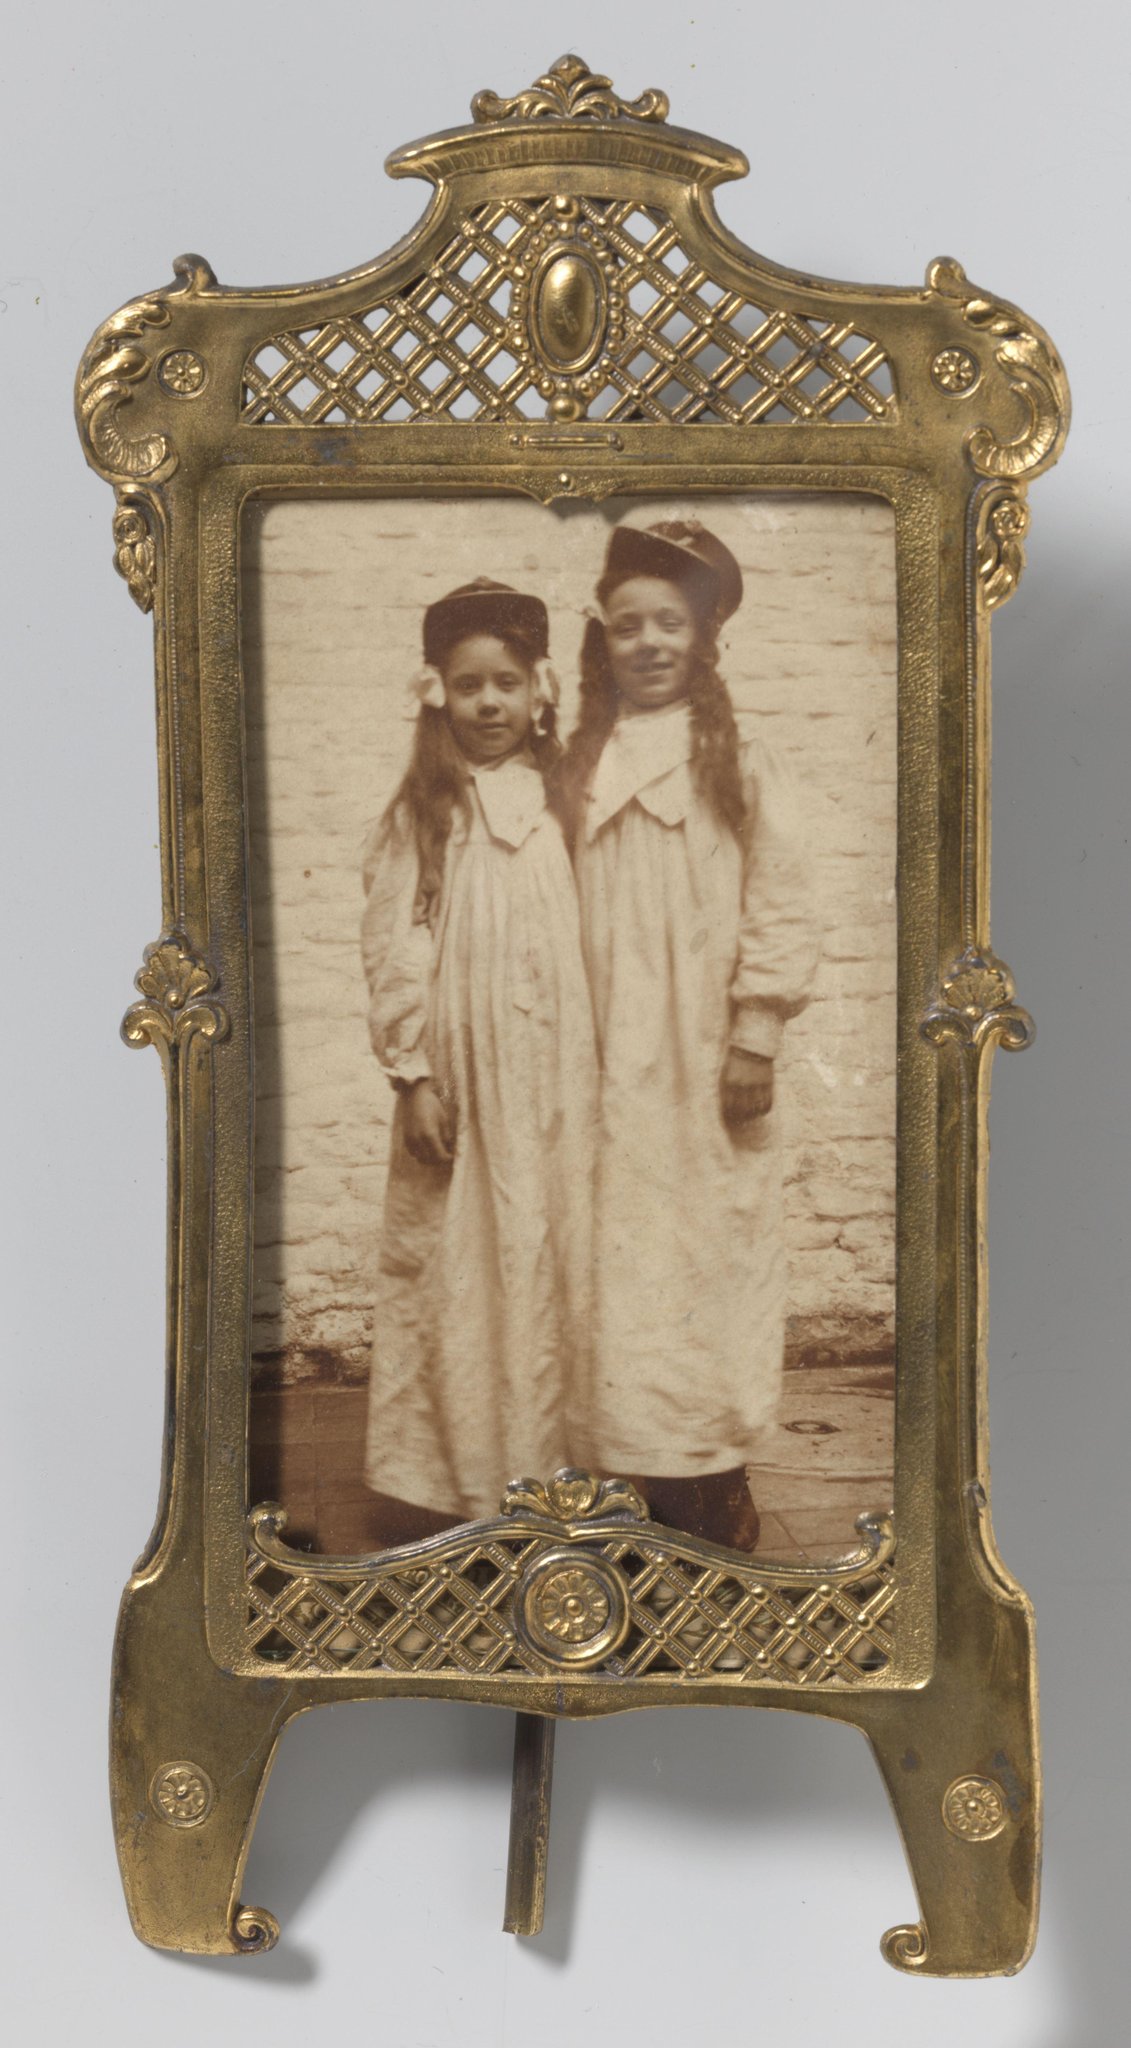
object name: photograph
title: Portret van twee onbekende meisjes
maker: Anonymous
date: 1890-1910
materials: paper, cardboard, glass, metal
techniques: gelatin silver print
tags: girl (child between toddler and youth), anonymous historical person portrayed